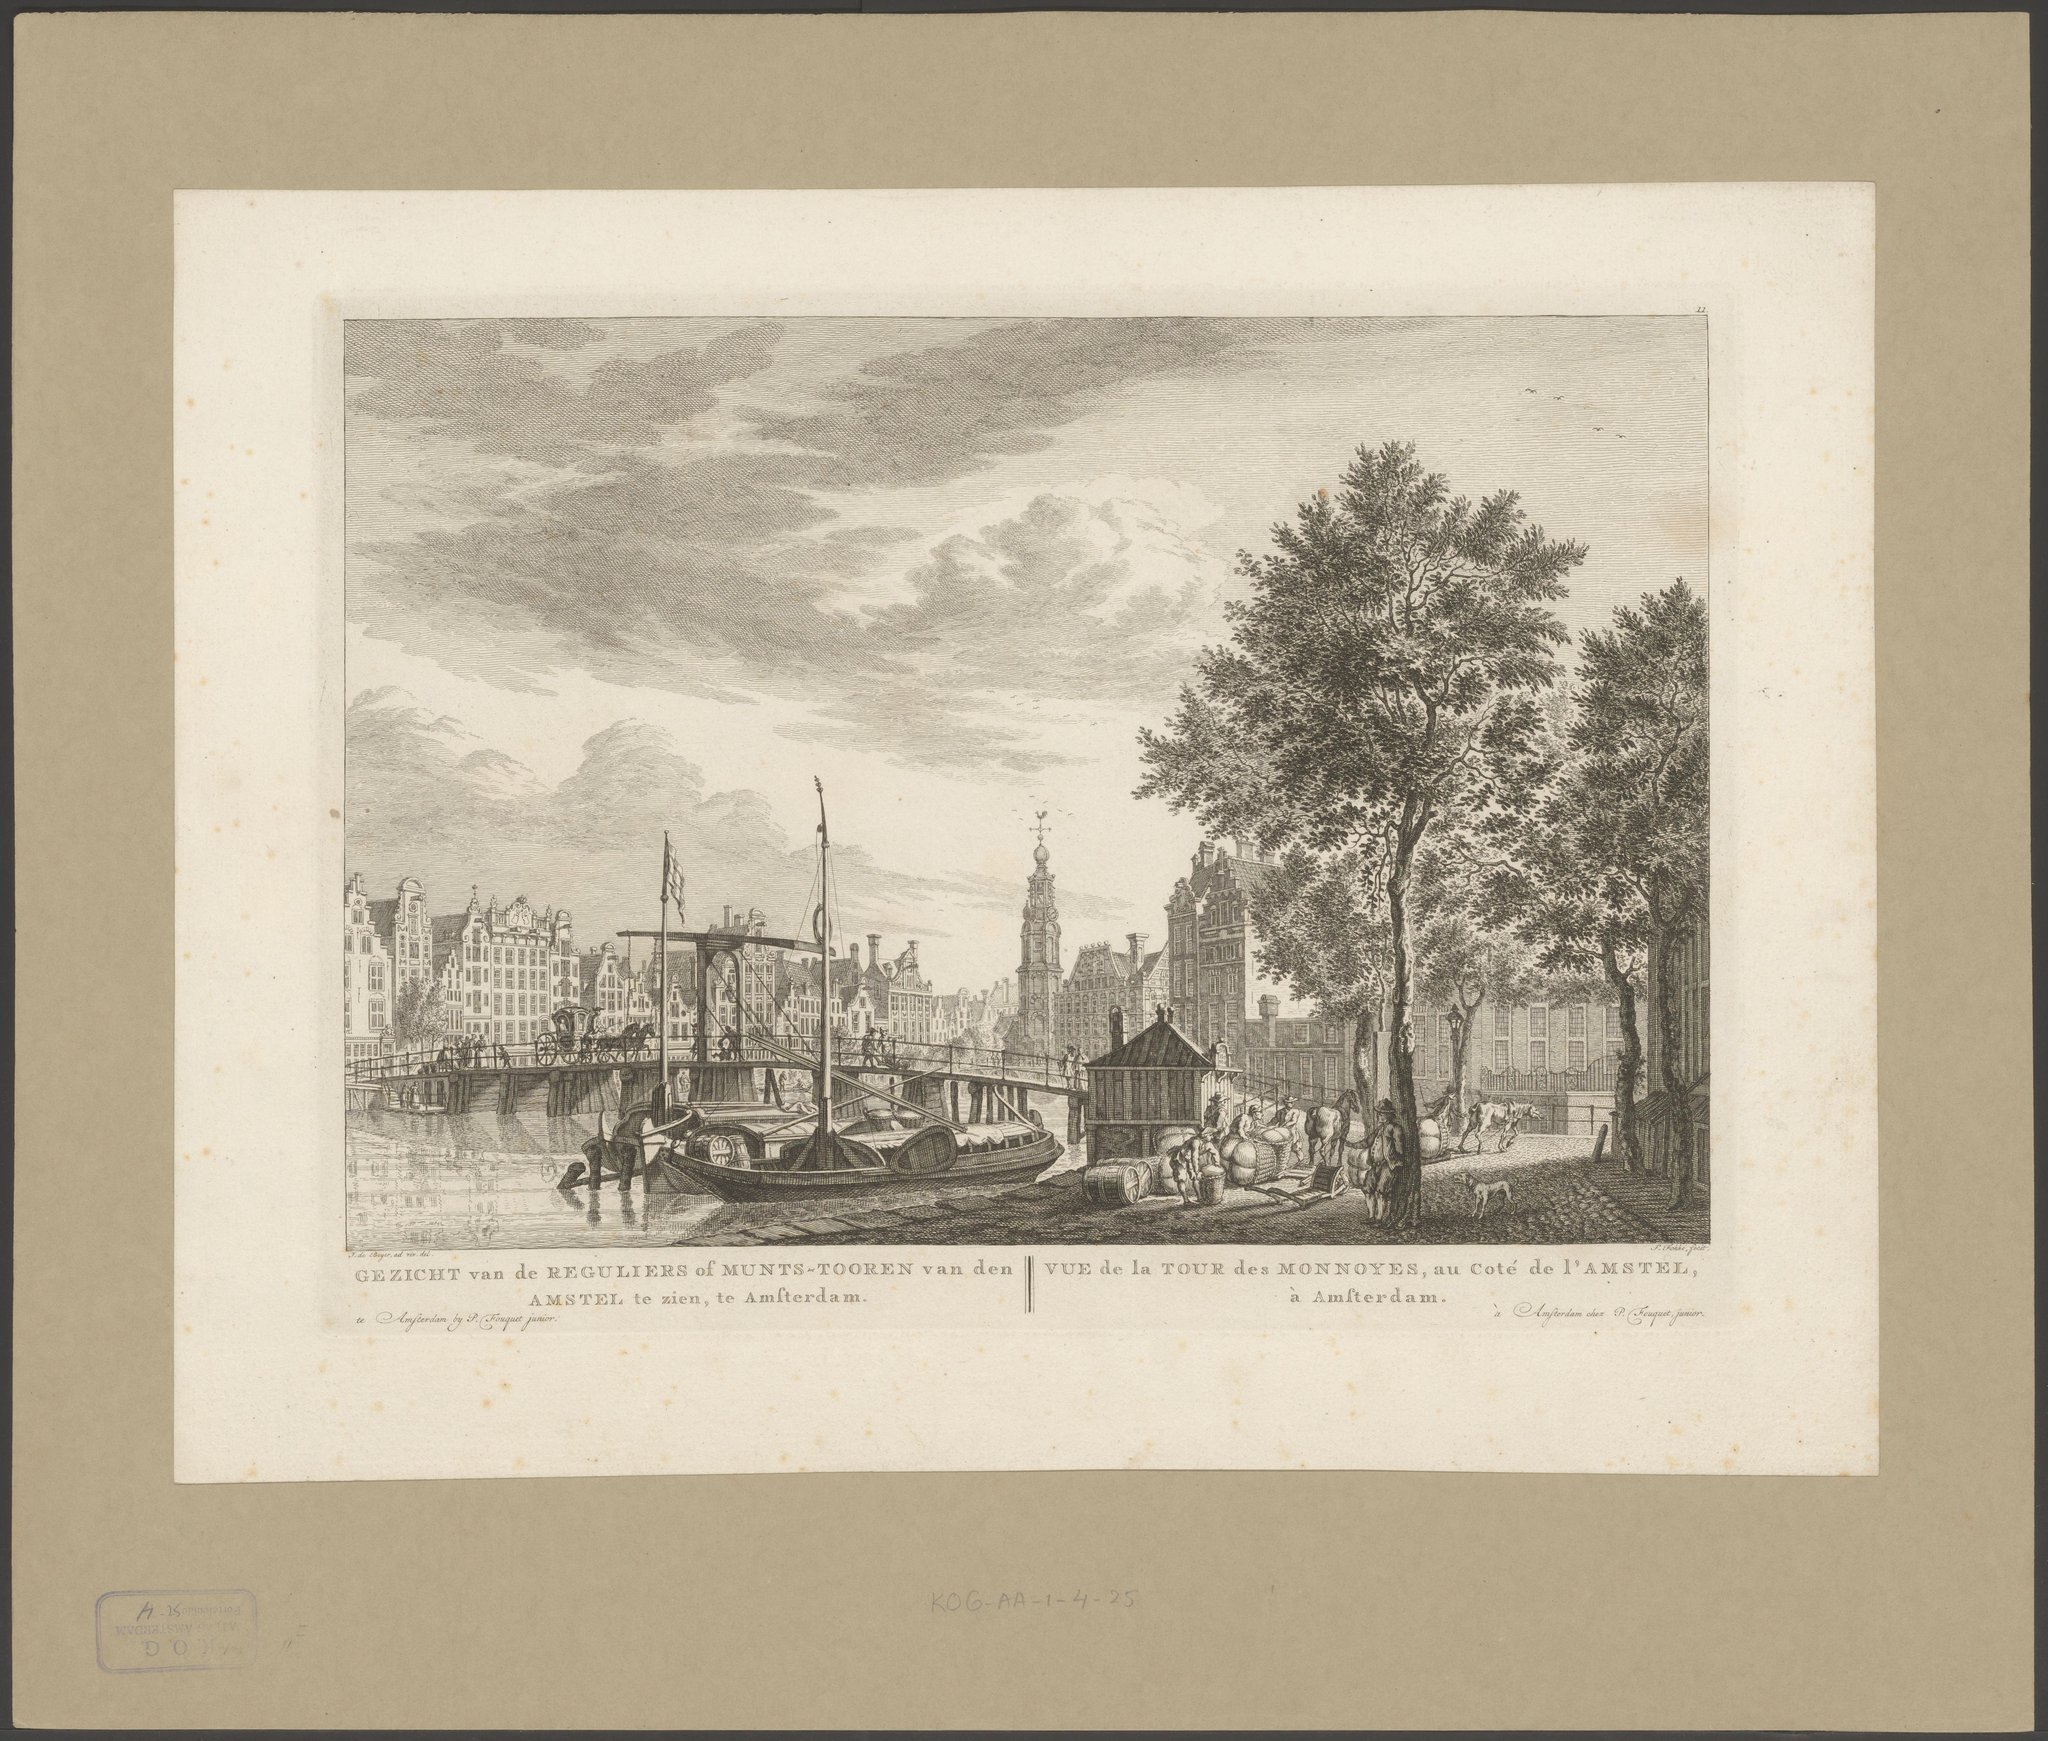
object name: print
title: Gezicht van de Reguliers of Munts-Tooren van den Amstel te zien, te Amsterdam / Vue de la Tour des Monnoyes, au coté de l'Amstel, à Amsterdam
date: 1760-1783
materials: paper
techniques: engraving, etching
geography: amsterdam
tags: tower, clock tower ~ monumental adornment, city-view in general; 'veduta', canal, bridge in city across river, canal, etc.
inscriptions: collector's mark: ‘4-25’ Lugt 1641b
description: Deze prent is ook gebruikt in de zogenaamde Atlas van Fouquet.* Pierre Fouquet gaf vanaf 1760 stadsgezichten van Amsterdam - naar tekeningen van verschillende kunstenaars, gemaakt door verschillende prentmakers - uit. Deze prenten werden aanvankelijk los of in series verkocht. Zoals toen gebruikelijk kon de koper de prenten zelf laten inbinden. Hiertoe gaf Fouquet tussen 1778 en 1783 een titelblad, plattegrond en inhoudsopgave van de tot dusver 100 uitgegeven prenten uit (1). Gezien de inhoud afhankelijk was van wat de koper had verzameld verschilt de inhoud van de verschillende bewaarde Fouquetatlassen onder deze titel sterk. Ook zijn er exemplaren bekend waar tevens andere prenten aan zijn toegevoegd. Omdat er behoefte bleek aan uitleg bij de platen werd in 1783 een nieuwe versie van de atlas uitgegeven, aangevuld met tekst en twee prenten. De aangegeven volgorde veranderde maar de platen van de al eerder uitgegeven prenten bleven ongewijzigd. Deze uitgave werd in opdracht van Fouquet gedrukt bij Daniël Jean Changuion en Petrus den Hengst (2). Een tiental platen werd bijgewerkt en verscheen, met nieuw impressum, in het vervolg van Wagenaars geschiedenis van Amsterdam, uitgeven door Petrus Conradi en Folkert van der Plaats (3). Een aantal jaar na het overlijden van Fouquet kwam Evert Maaskamp met een nieuwe uitgave van de atlas, met verbeterde tekst en toevoeging van twee prenten. Op alle platen verwijderde hij het oude en liet hij zijn eigen impressum zetten (4). De huidige staat van de prent komt voor in exemplaren van de onder (1) en (2) genoemde werken. * Onder de Atlas van Fouquet of Fouquetatlas verstaan we de hieronder vermelde publicaties (1), (2) en (4). (1). Afbeeldingen van de wyd-vermaarde koopstad Amsterdam benevens des zelvs voornaamste gebouwen en gezigten alle naar het leeven getekend / Receuil des edifices les plus considerables et des plus belles vues, de la fameuse ville d'Amsterdam, dessinées d'après nature. Amsterdam: Pierre Fouquet, 1778-1783. (2). Nieuwe atlas, van de voornaamste gebouwen en gezigten der stad Amsterdam, met derzelver beknopte beschryvingen. 2 delen. Amsterdam: Daniël Jean Changuion en Petrus den Hengst [in opdracht van Pierre Fouquet], 1783. (3). Stijl, Simon. Amsterdam, in zyne geschiedenissen, voorregten, koophandel, gebouwen, kerkenstaat, schoolen, schutterye, gilden en regeeringe, beschreeven. Om te dienen ten vervolge op het werk van Jan Wagenaar (…). 10 delen. Amsterdam en Harlingen: Petrus Conradi en Folkert van der Plaats, 1788-1801. (4). Nieuwe atlas, van de voornaamste gebouwen en gezigten der stad Amsterdam. Met derzelver beknopte beschryvingen. Amsterdam: Evert Maaskamp, 1805. * Het aantal vermelde staten is gebaseerd op het aantal gevonden staten. Mogelijk zijn er meer staten van deze prent. Zie RP-P-1905-396 voor eerste of tweede bekende staat. Zie RP-P-1921-298 voor eerste of tweede bekende staat.